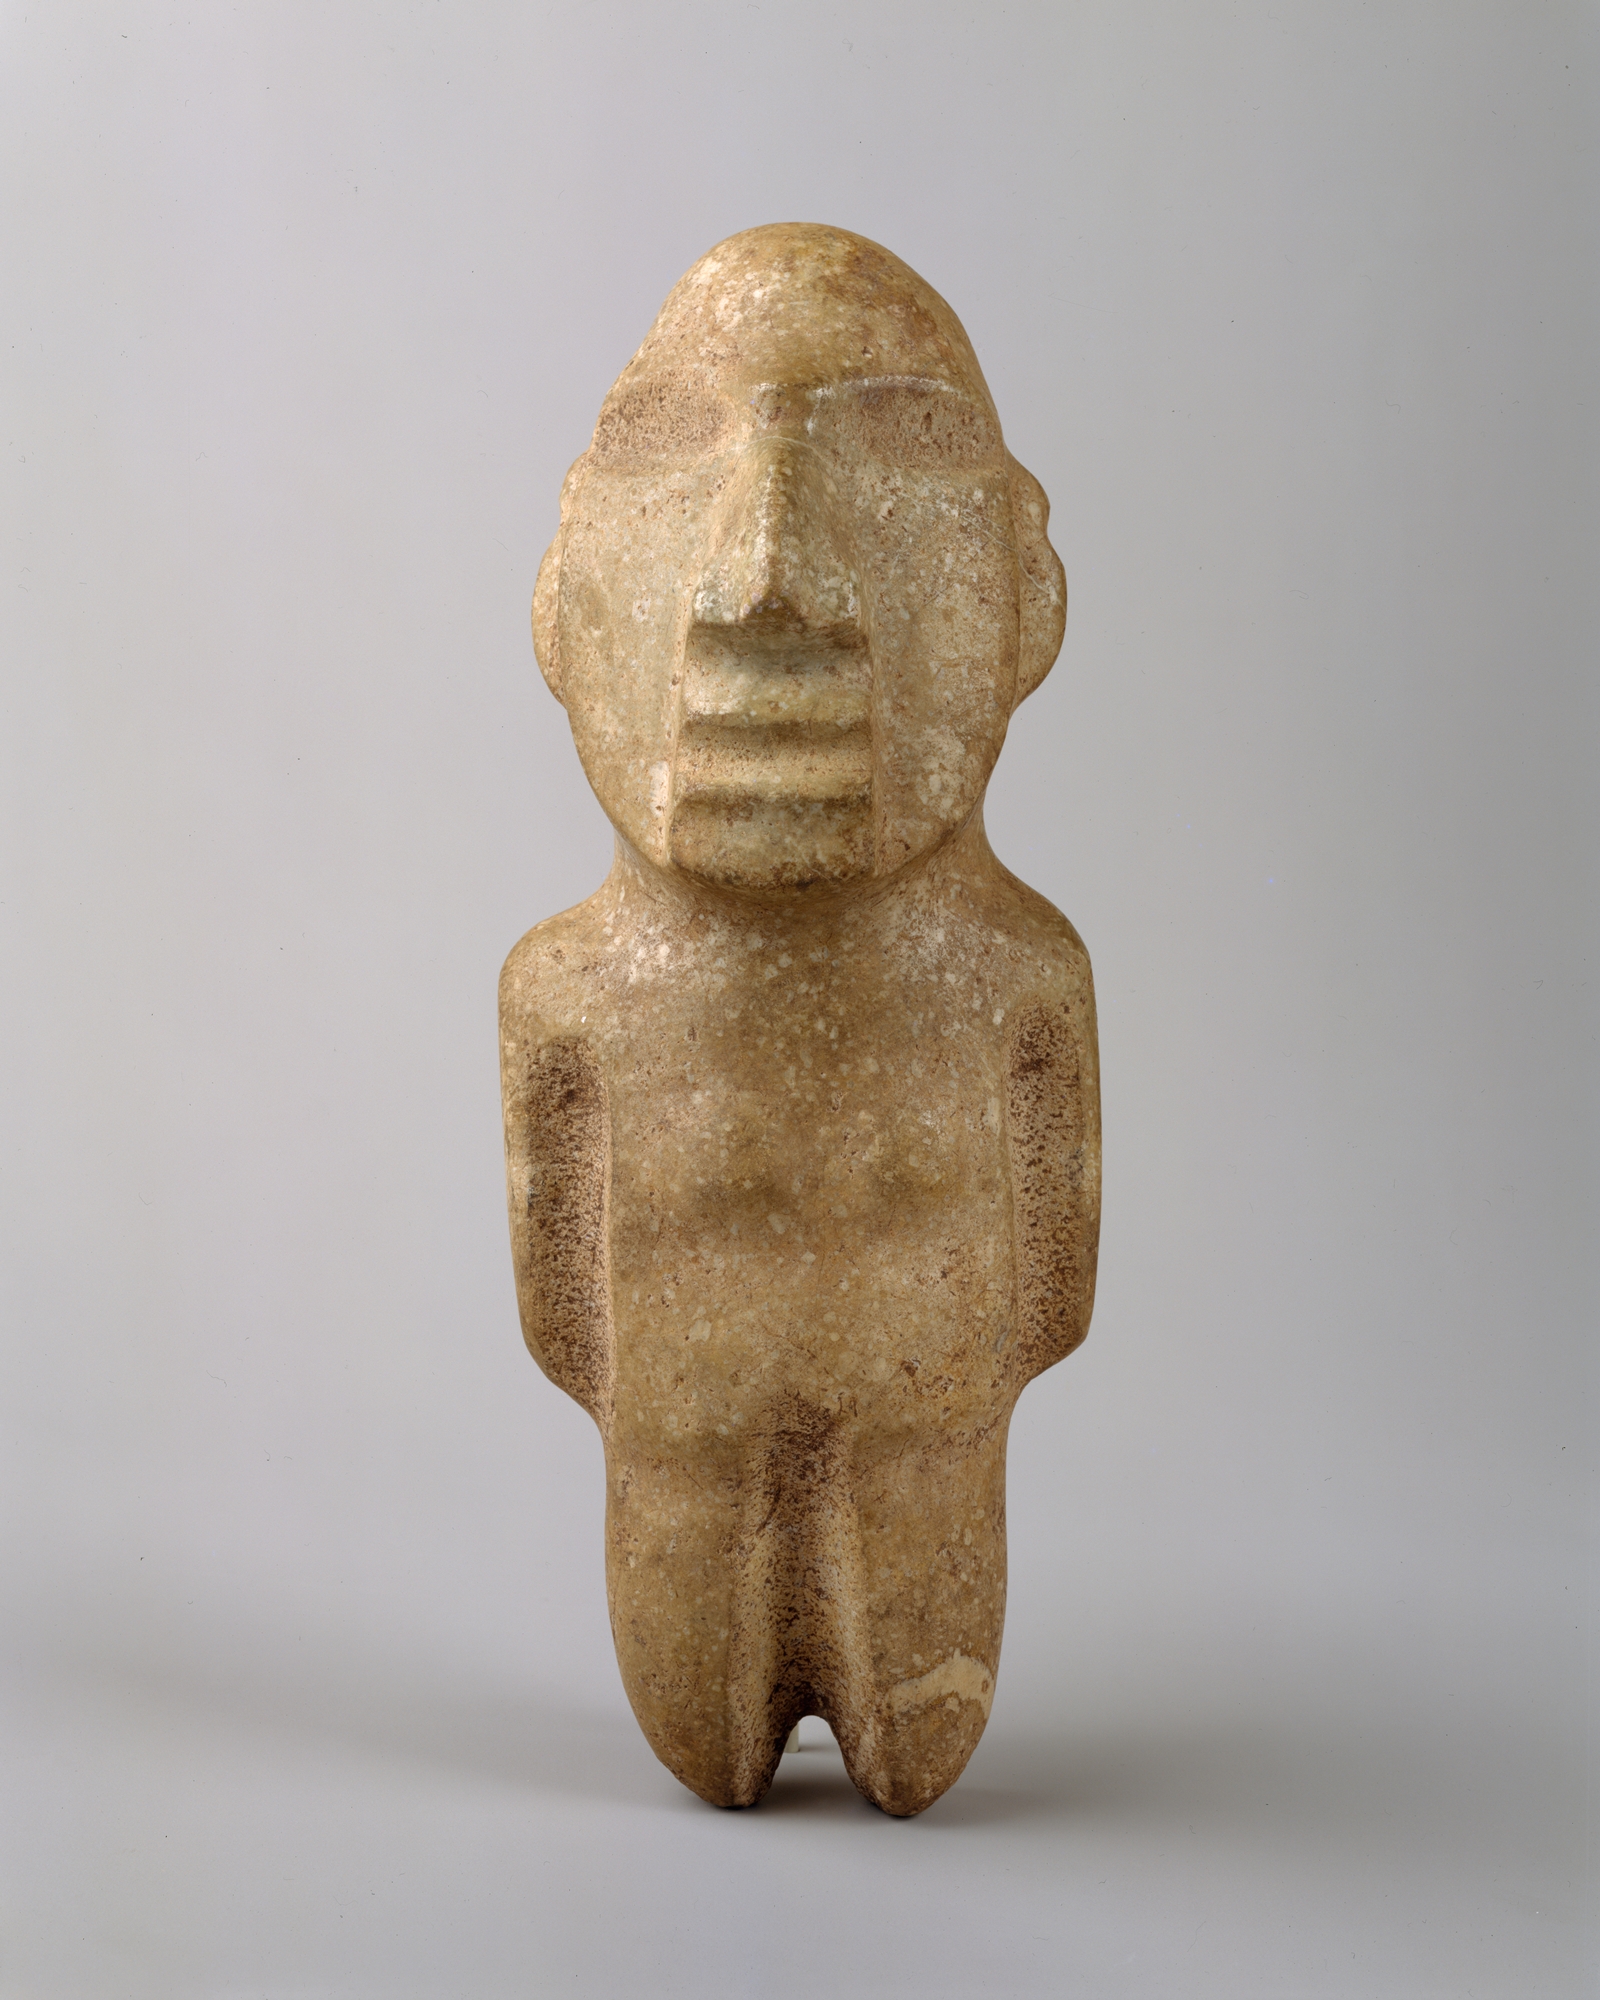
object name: figure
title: Standing Figure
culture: mexican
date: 500 BCE-1500 CE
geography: mexico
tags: human figures